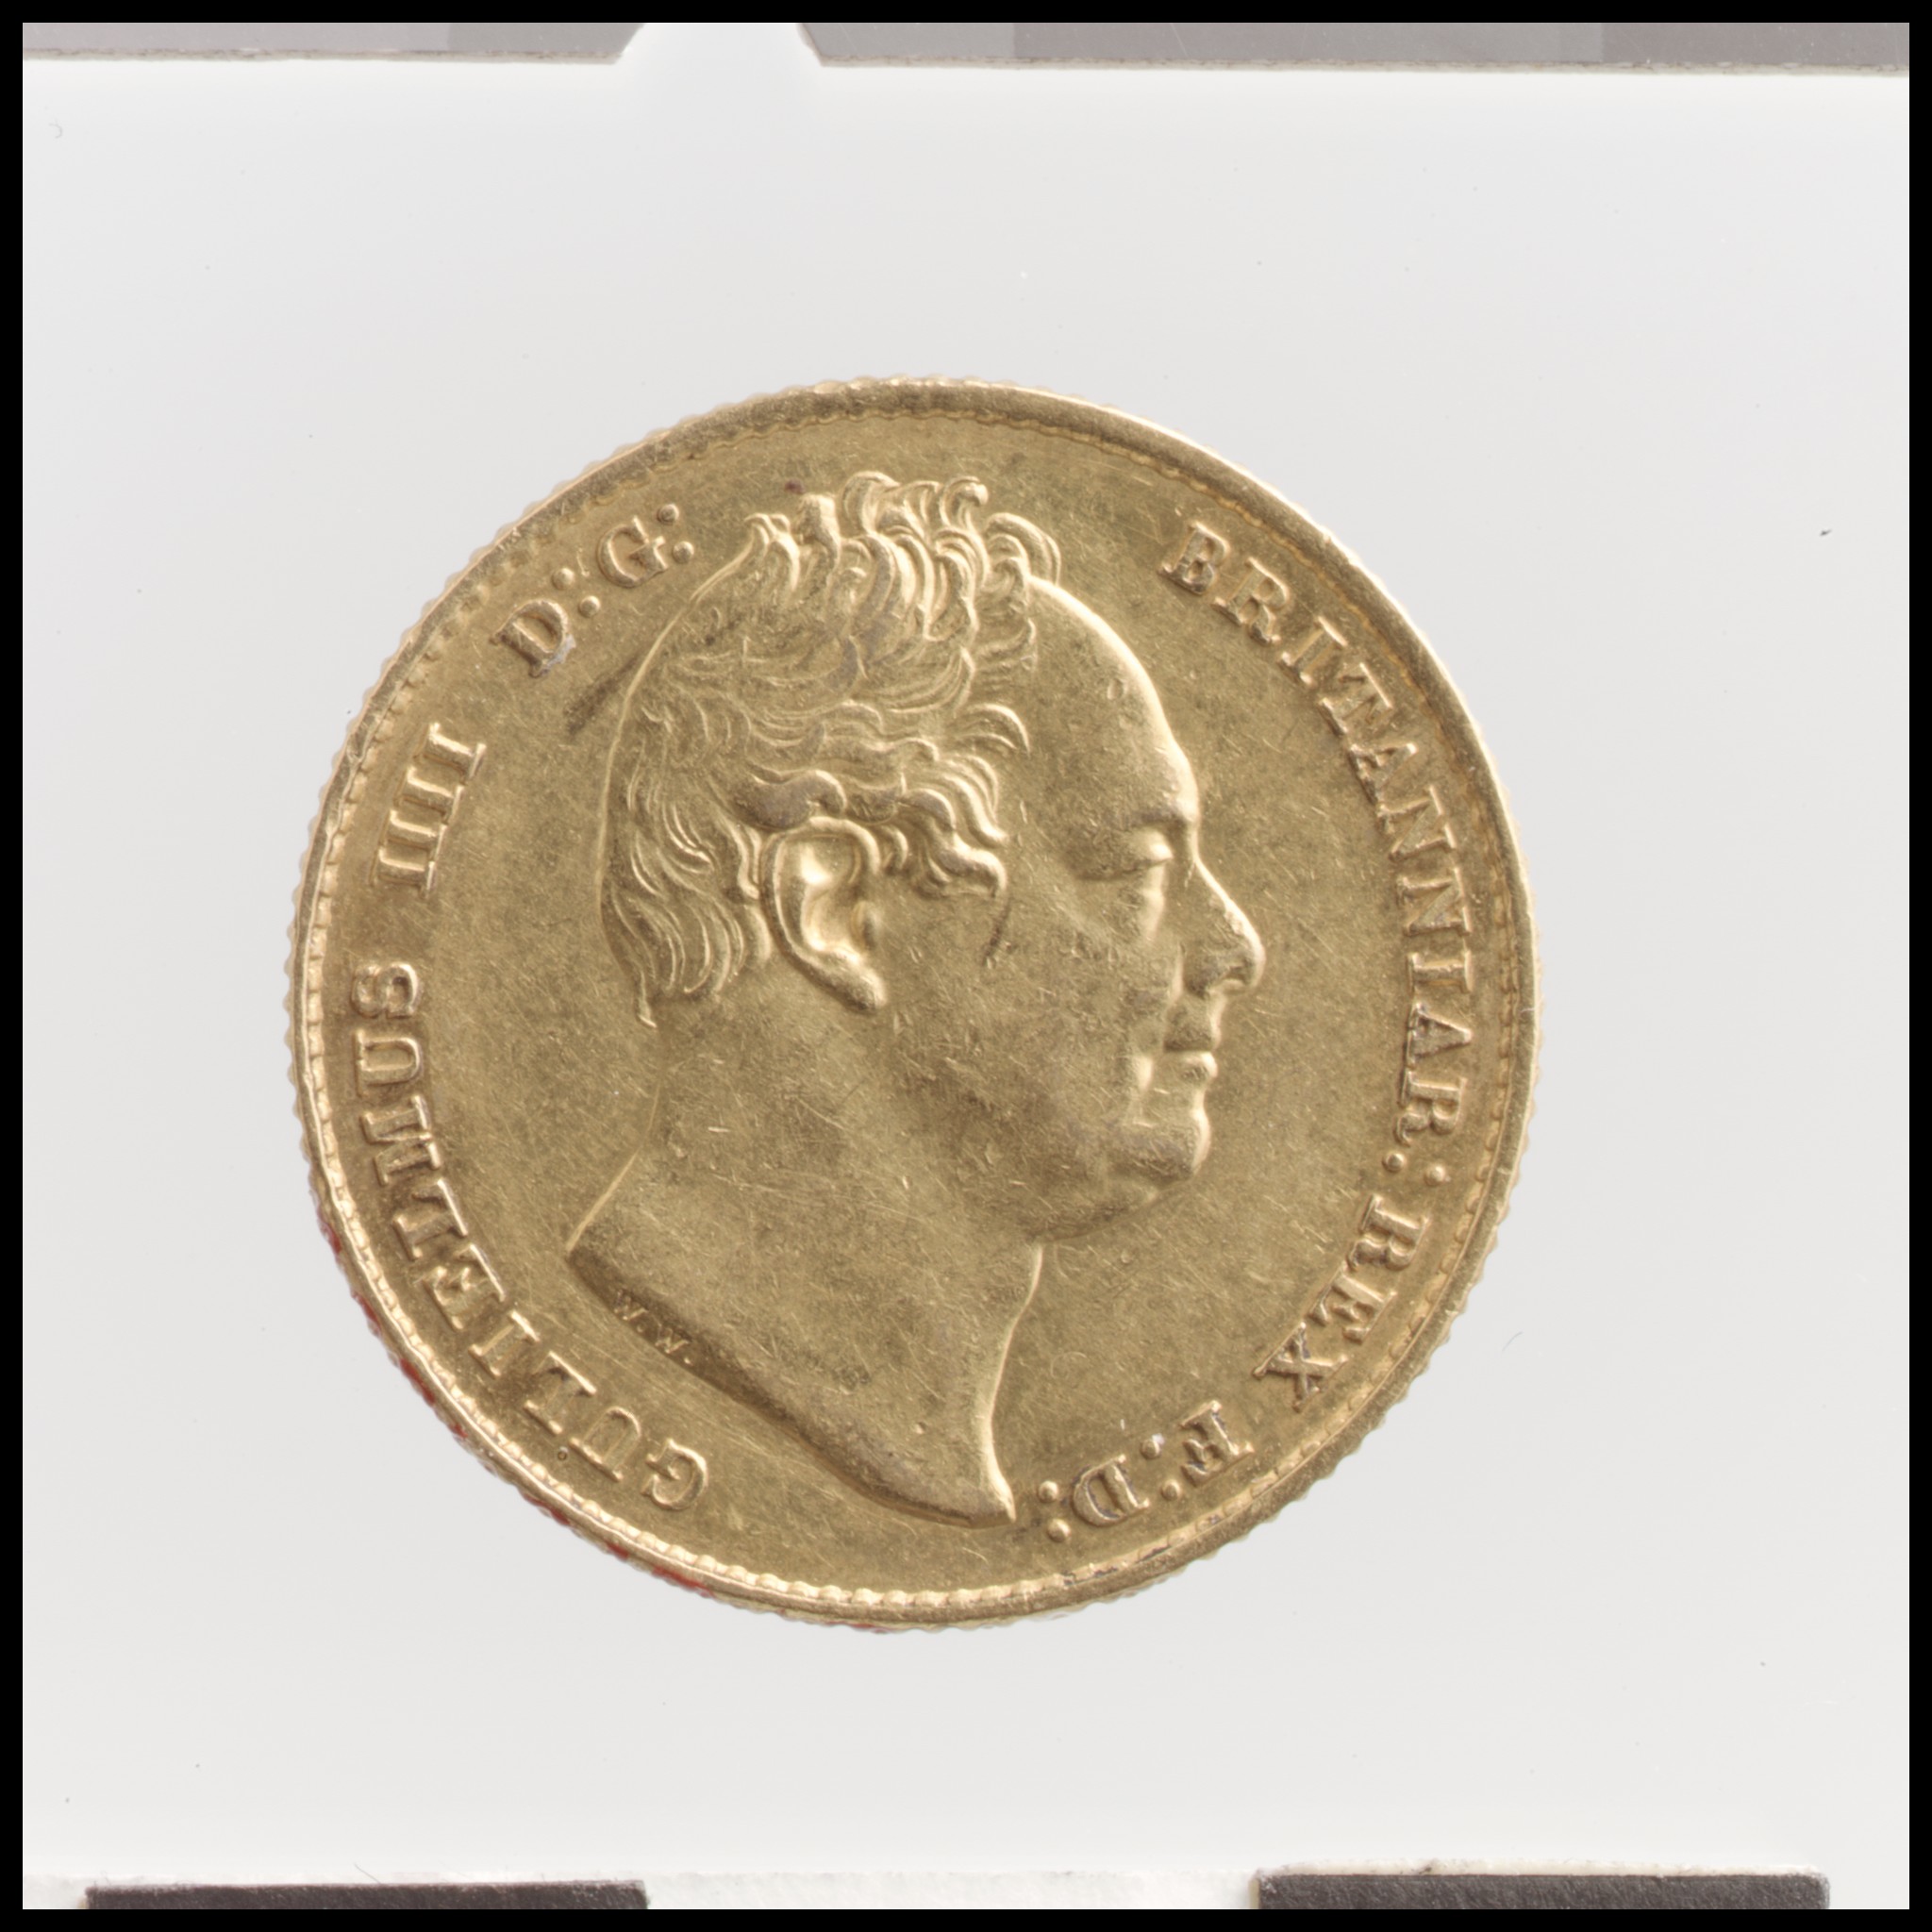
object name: sovereign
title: William IV sovereign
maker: william wyon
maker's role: artist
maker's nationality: british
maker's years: 1795-1851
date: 1832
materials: gold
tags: kings,profiles,coat of arms